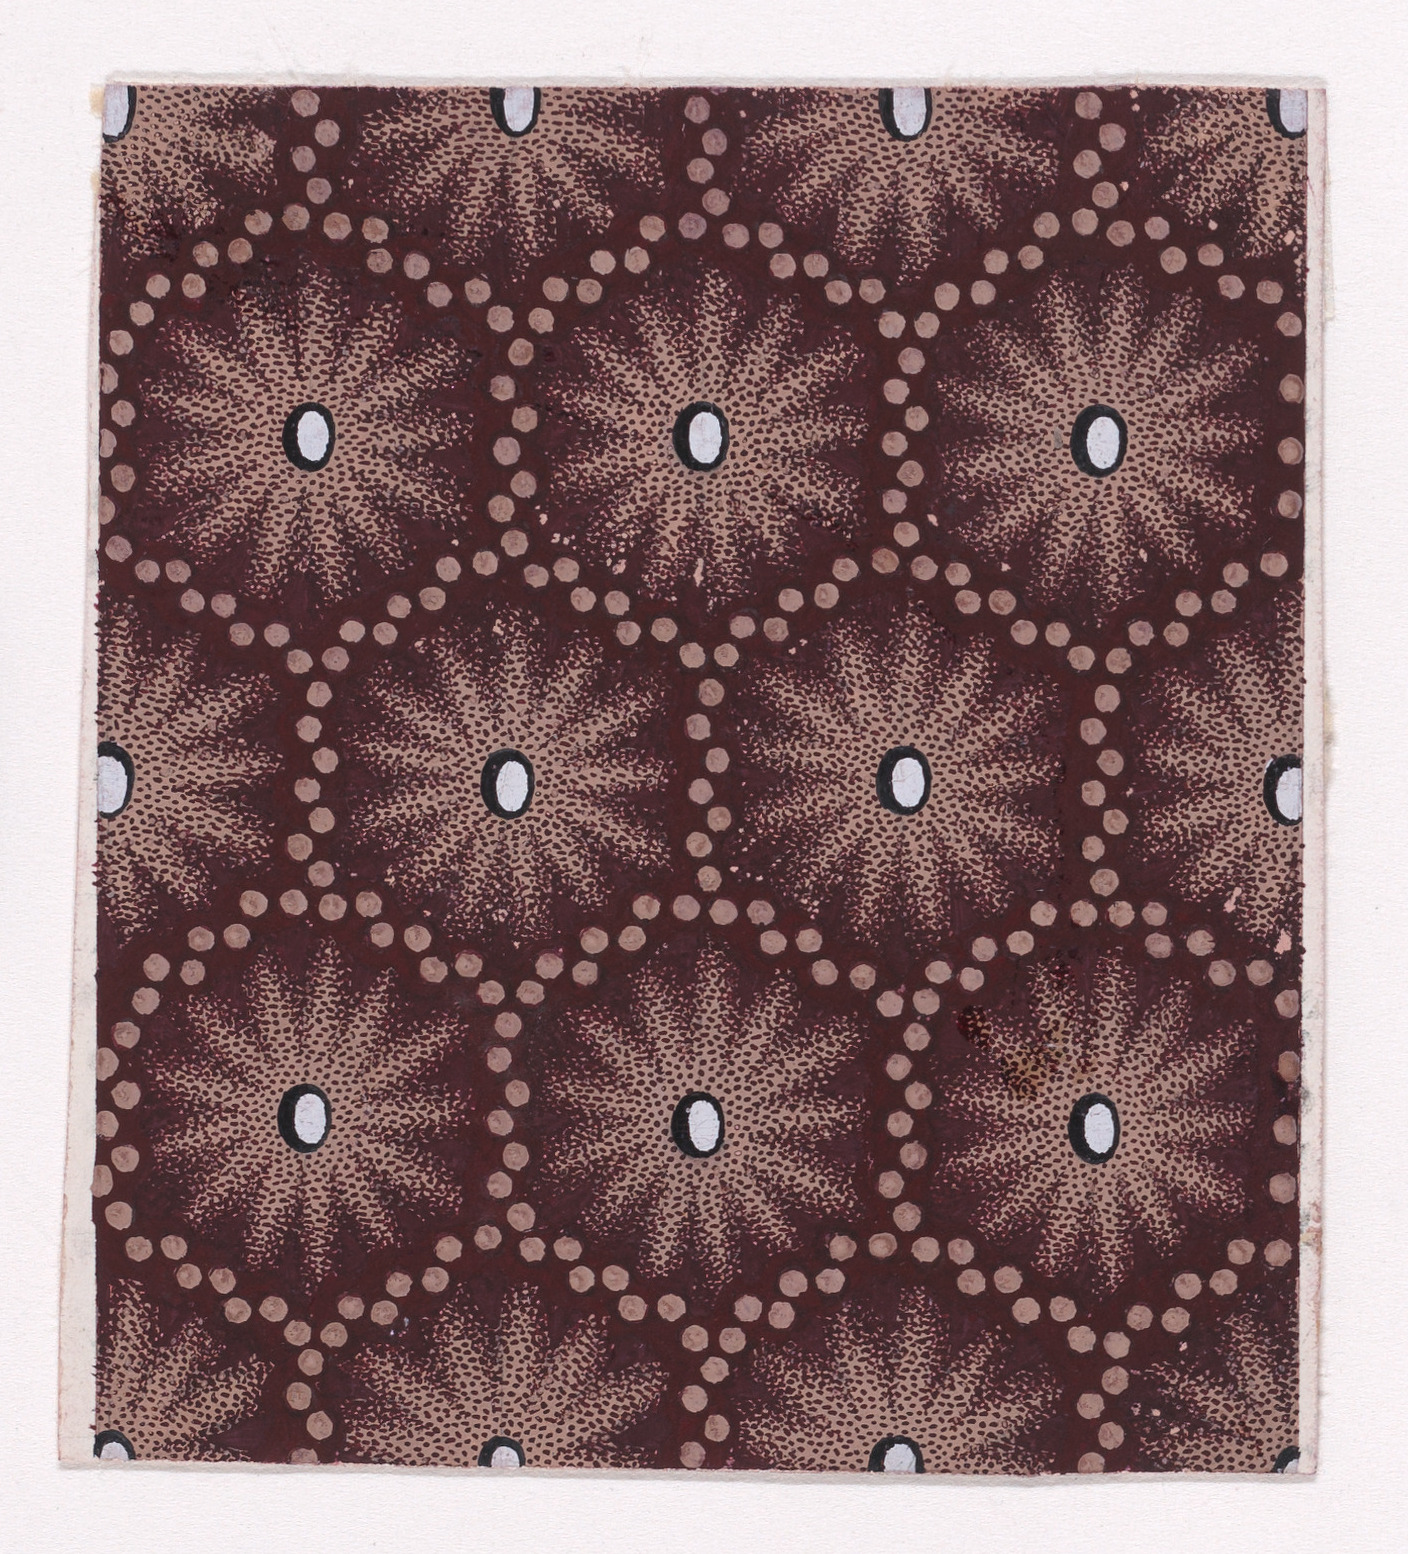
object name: drawing ornament architecture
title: Textile Design with a Honeycomb Pattern of Garlands of Dots and Pearls over a Stippled Background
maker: anonymous, alsatian, 19th century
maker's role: artist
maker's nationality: alsatian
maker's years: 1800-1900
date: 1840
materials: gouache